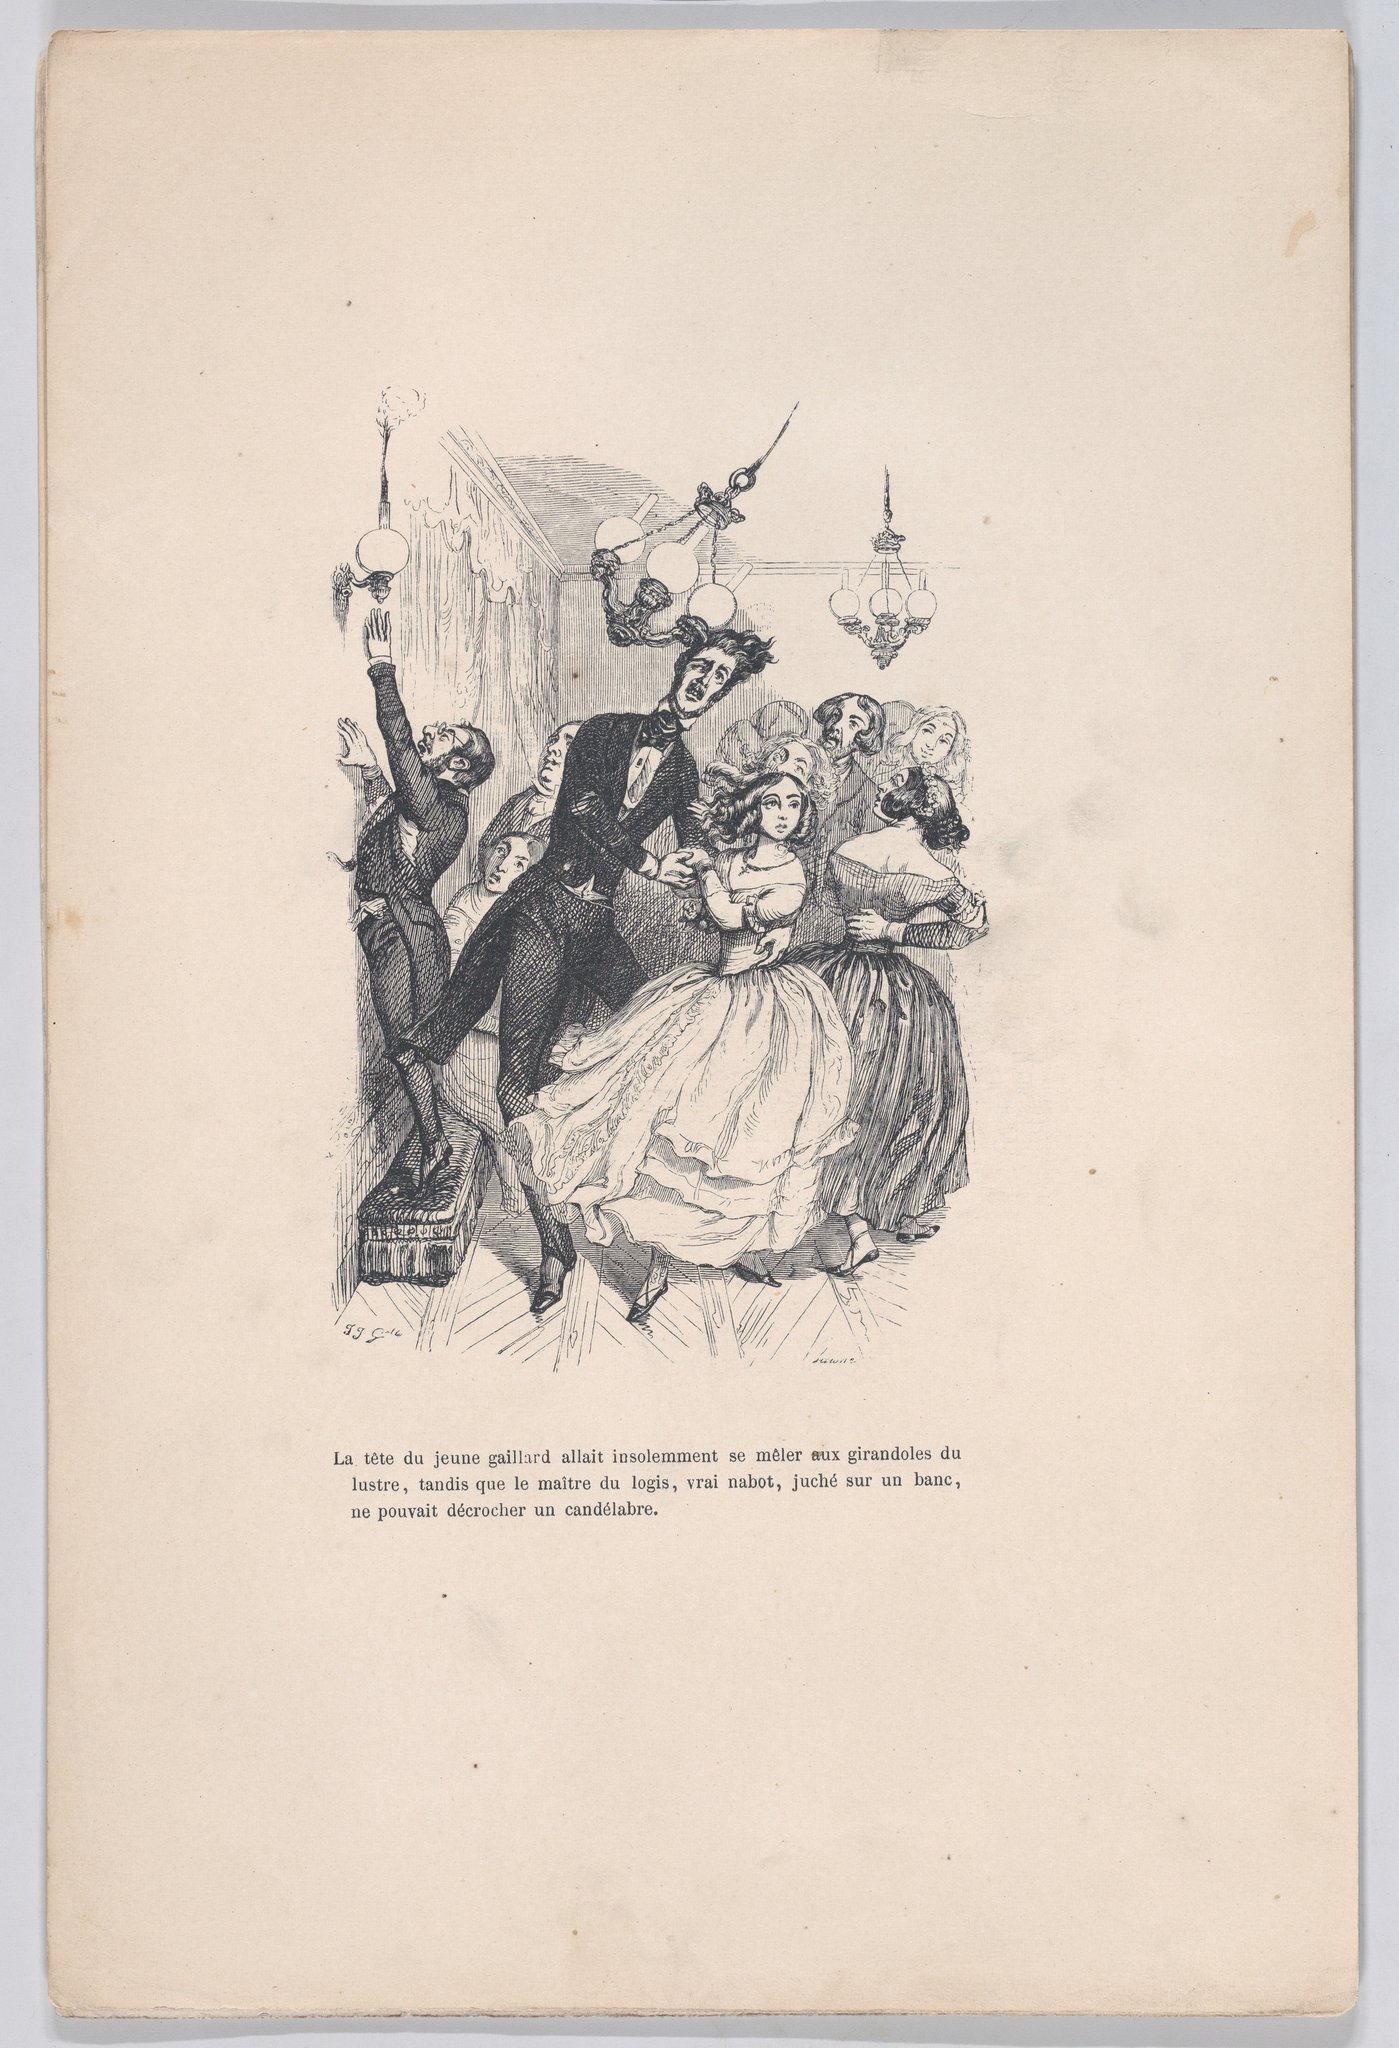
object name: print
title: The head of the young fellow insolently mingled with the candlesticks of the chandelier, from "Little Miseries of Human Life"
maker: j. j. grandville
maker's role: illustrator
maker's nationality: french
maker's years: 1803-1847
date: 1843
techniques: engraving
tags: men,women